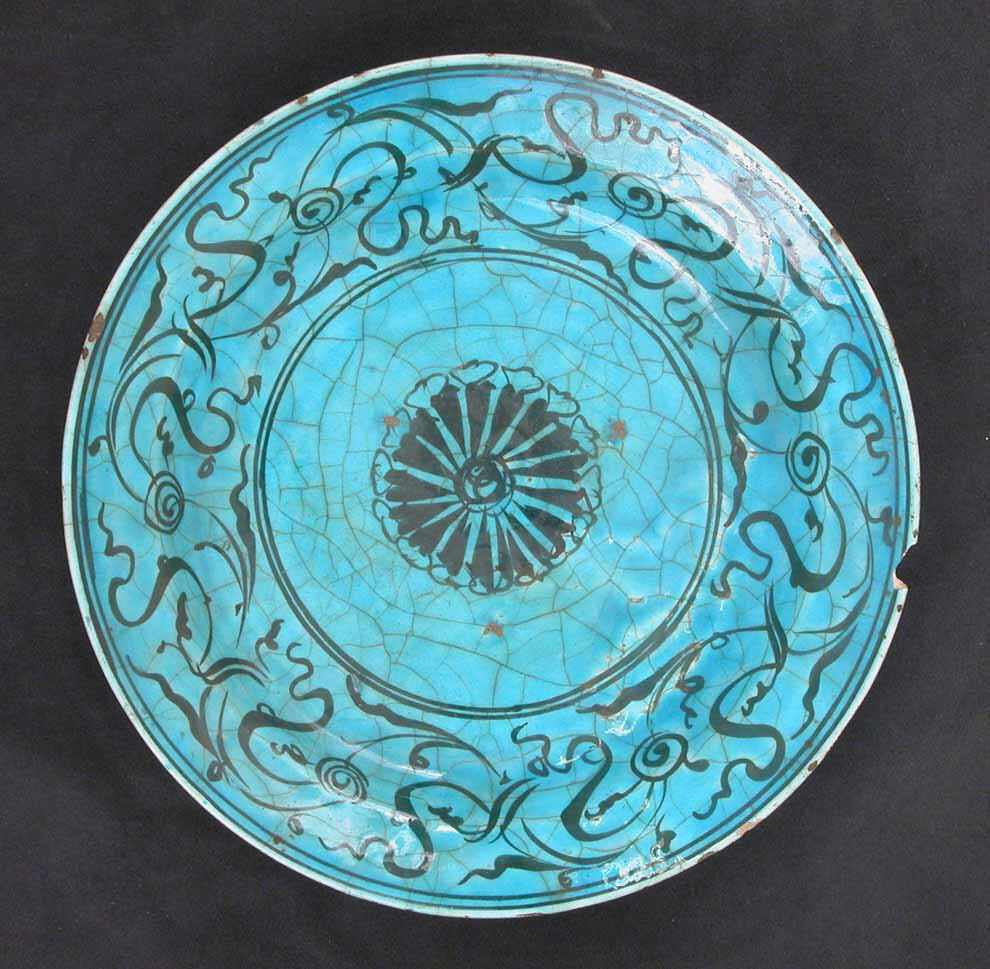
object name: dish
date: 1501-1700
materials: glaze, stonepaste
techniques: painting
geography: iran